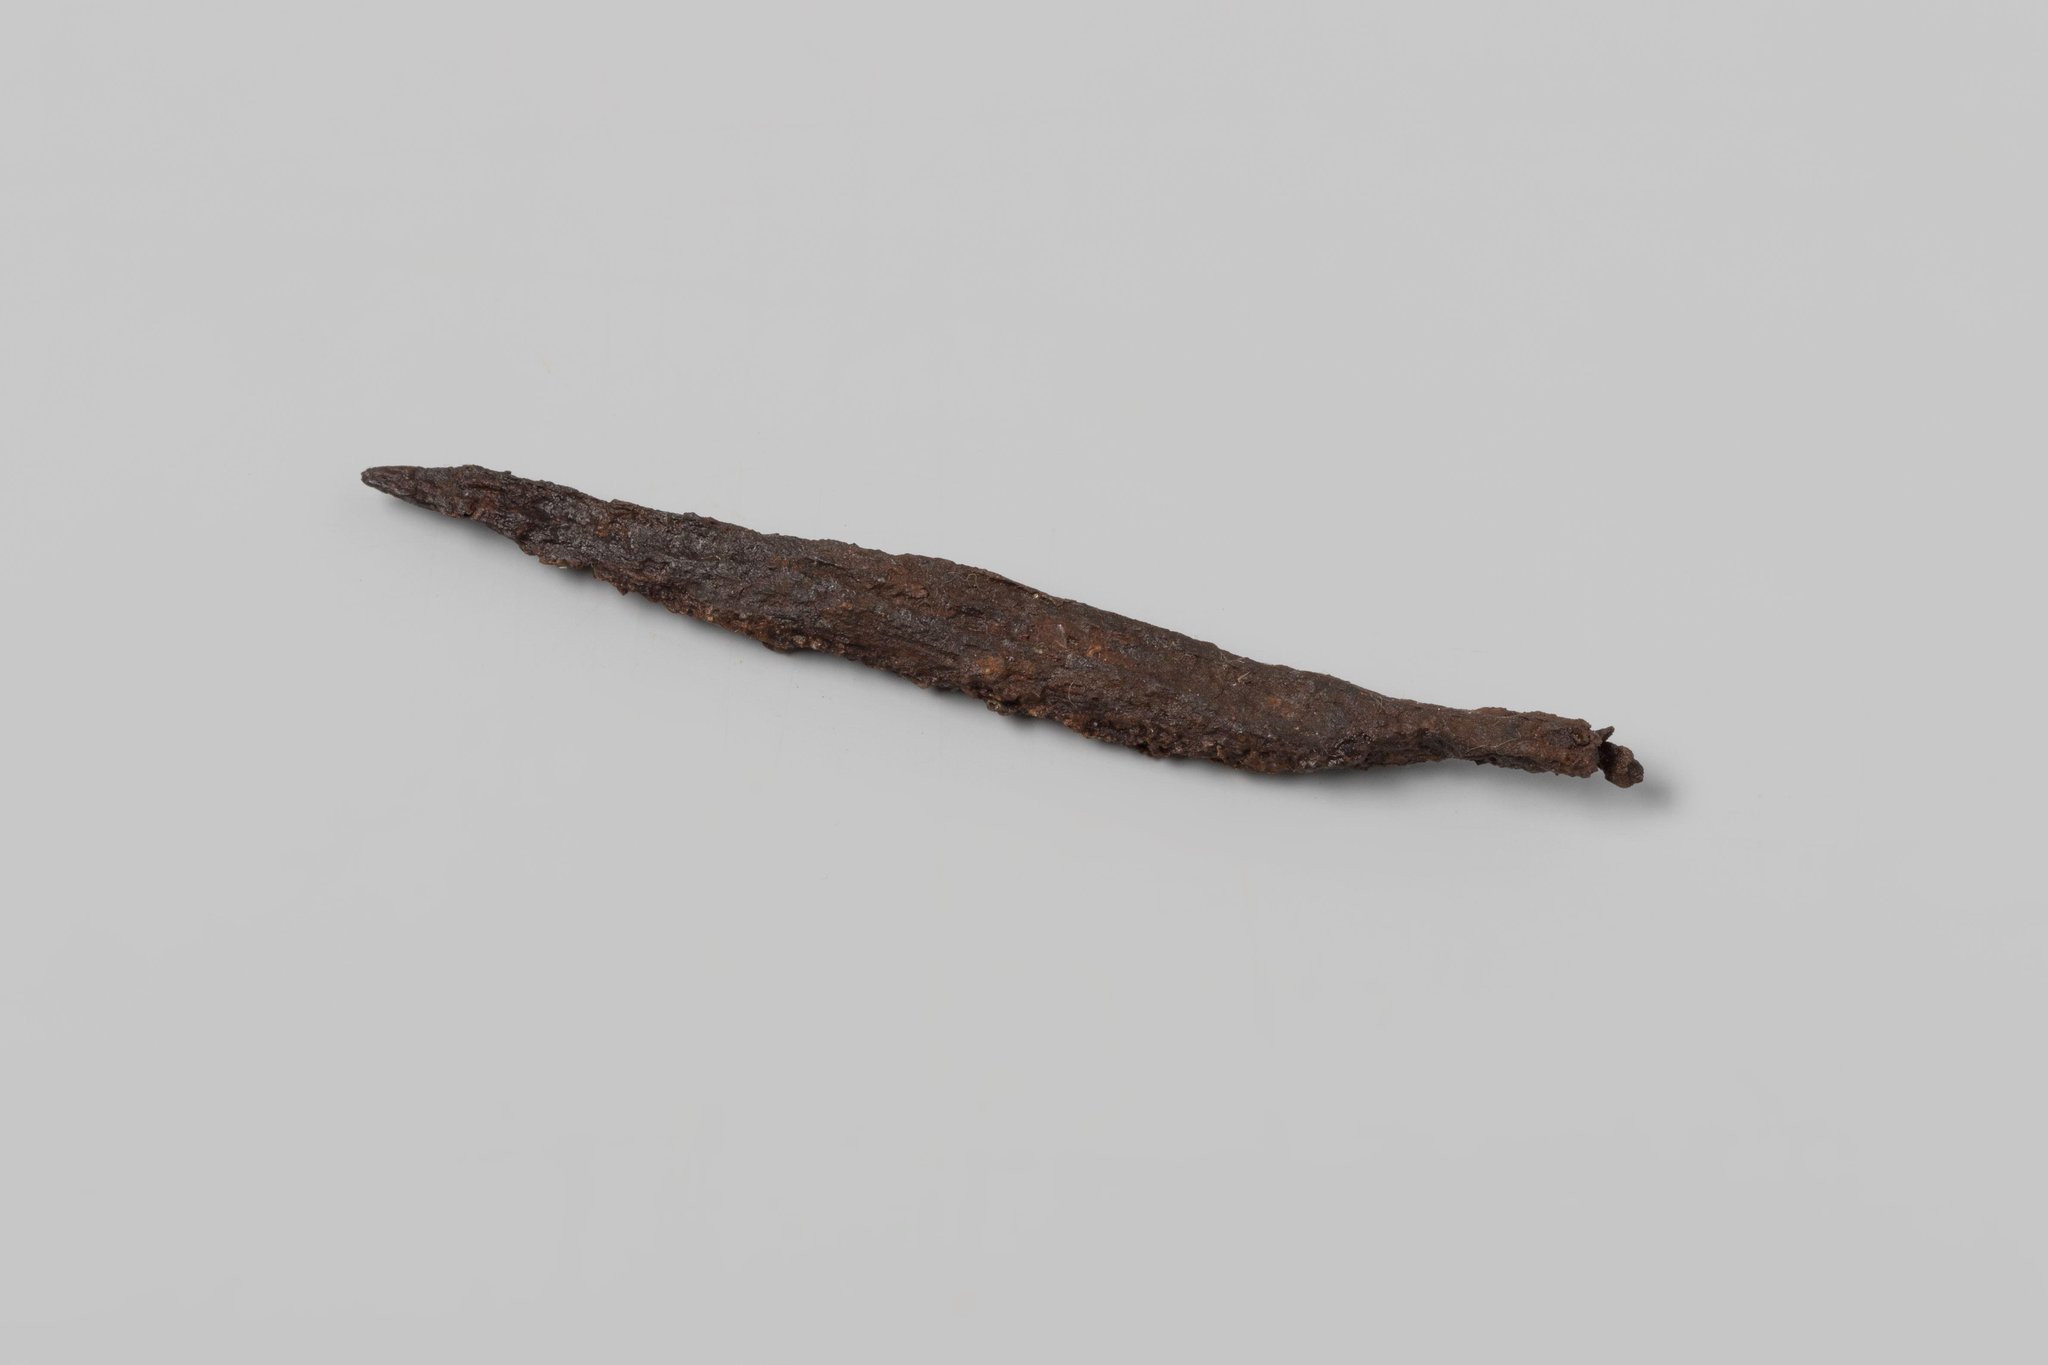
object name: fragment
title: Fragment ijzer uit het wrak van de Oost-Indiëvaarder Hollandia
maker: Anonymous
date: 1700-1743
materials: iron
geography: netherlands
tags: verenigde oostindische compagnie, hollandia (schip), annet